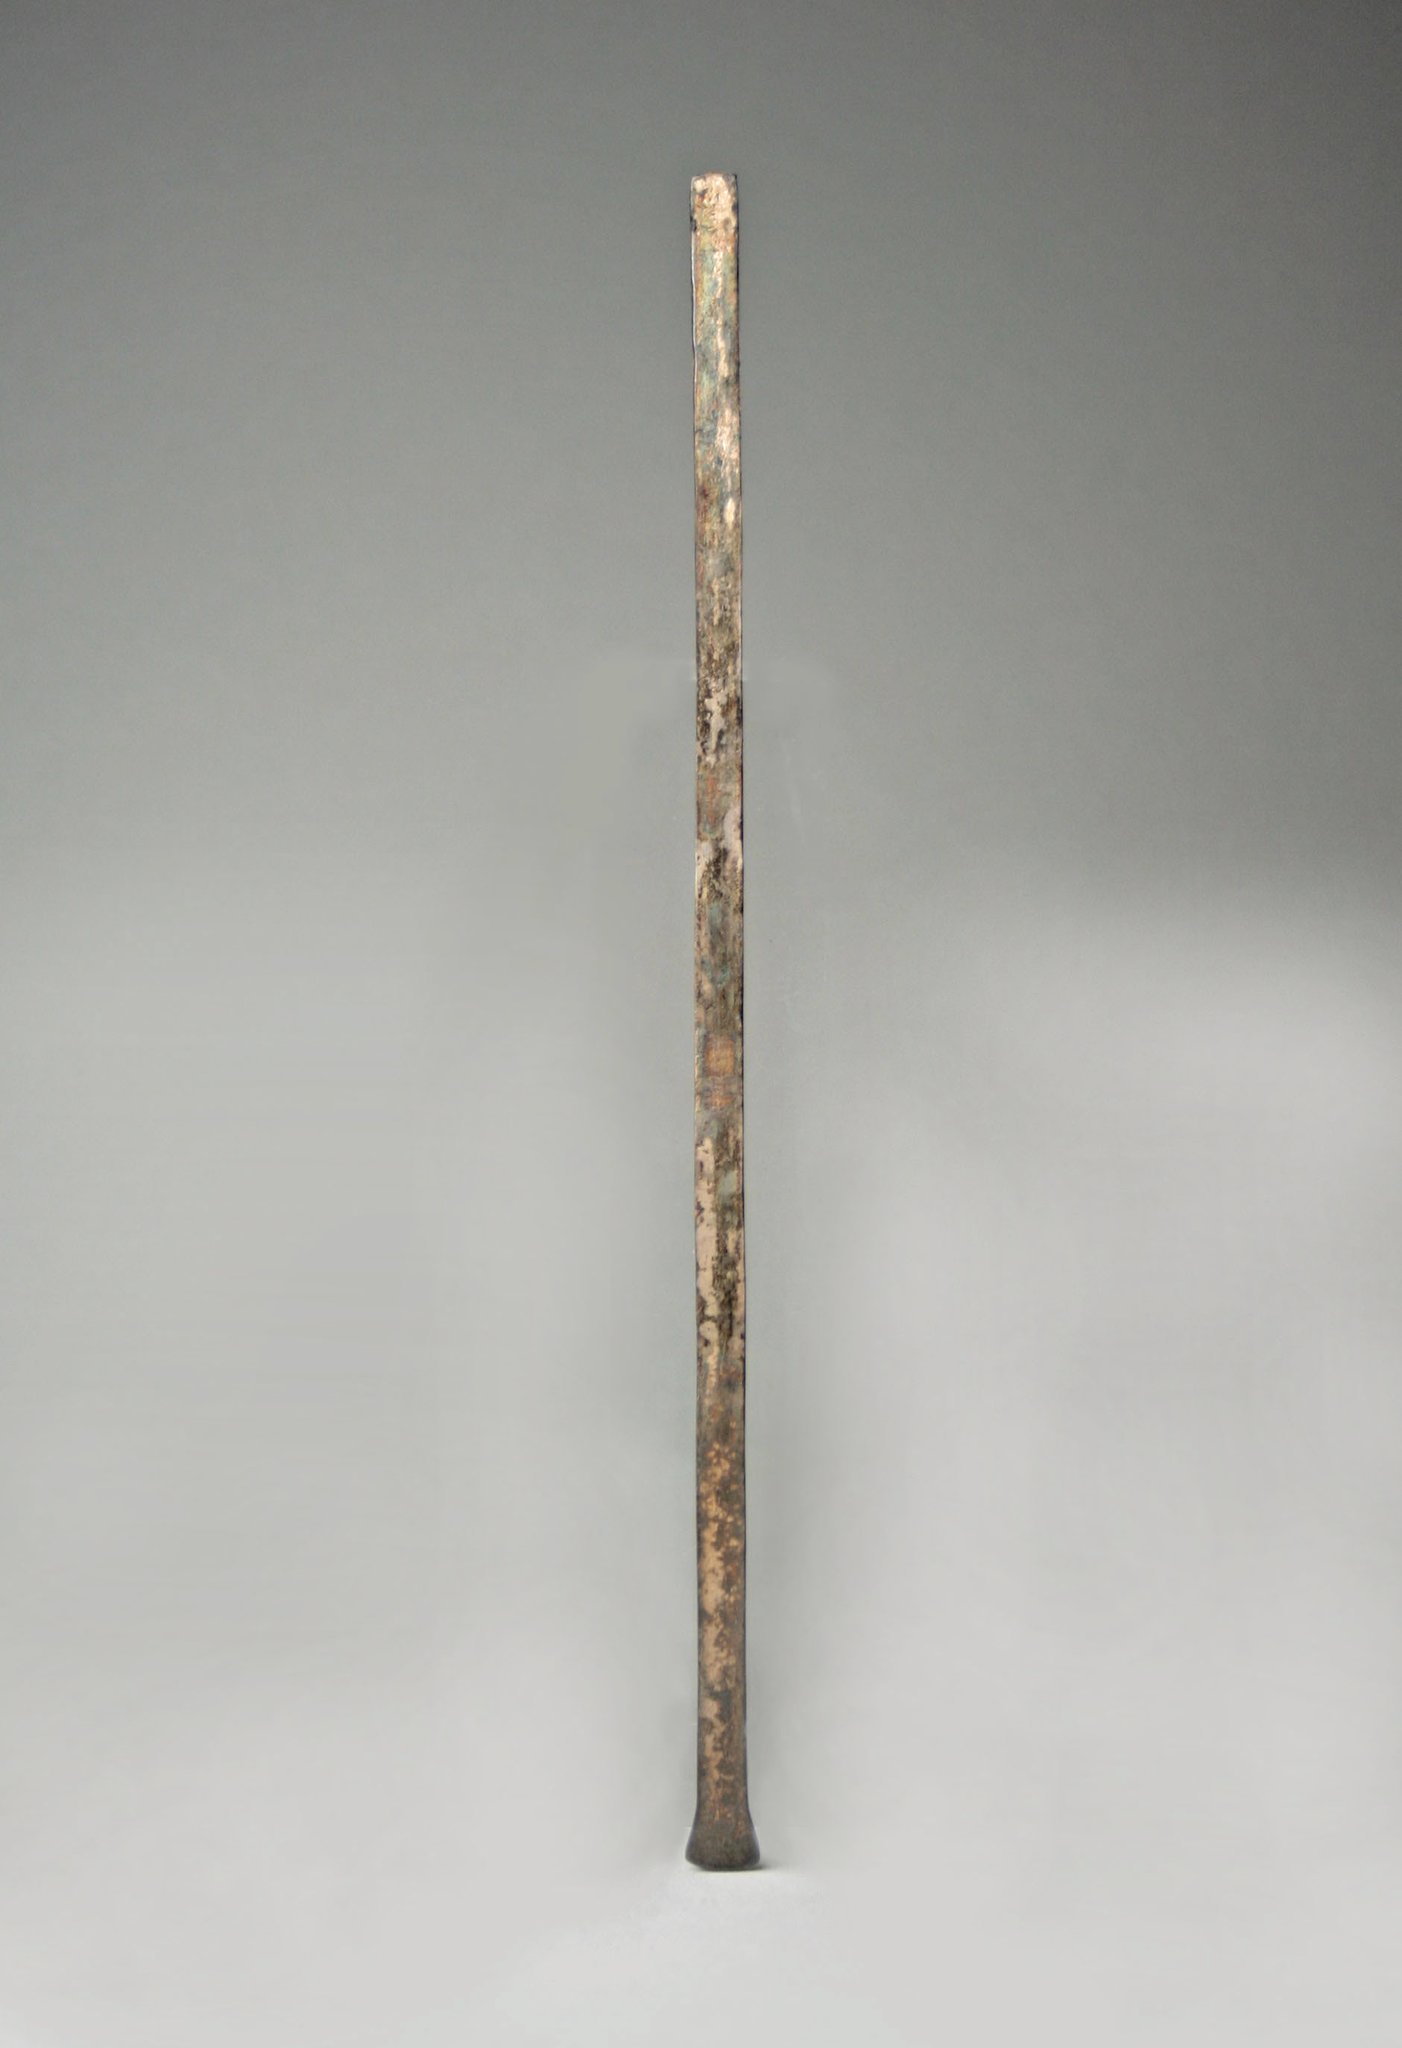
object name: spatula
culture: moche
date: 101-700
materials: silver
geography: peru